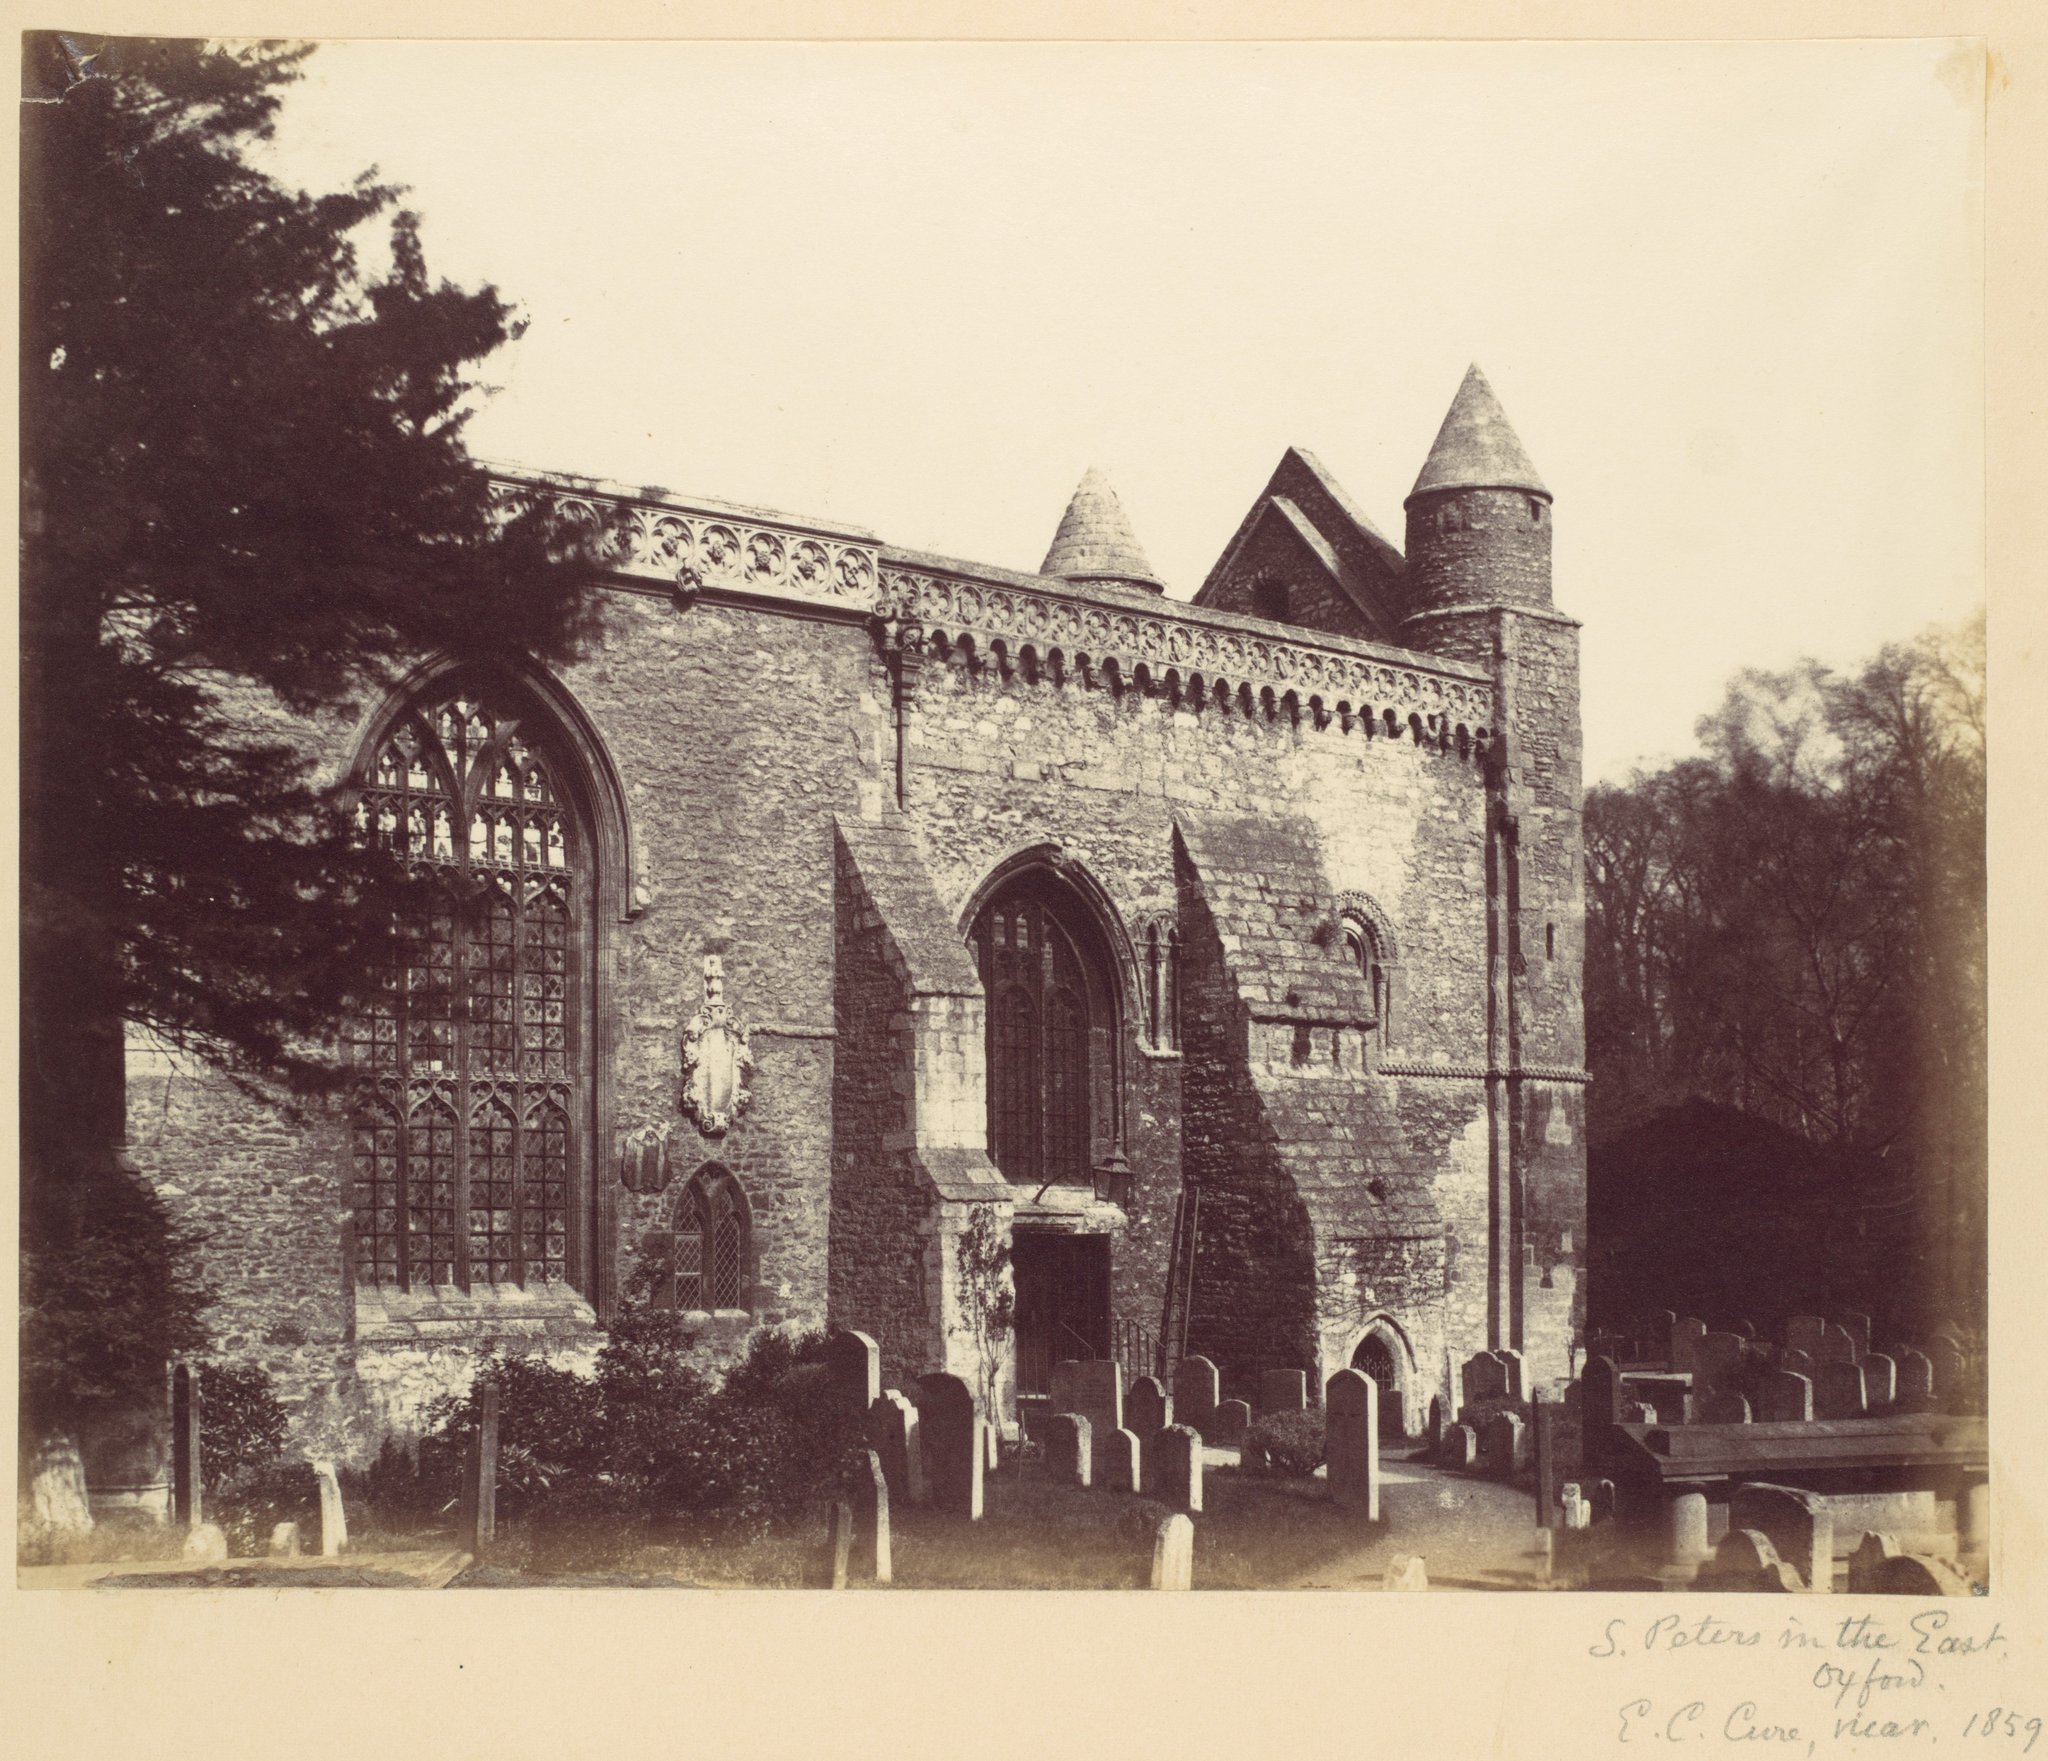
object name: photograph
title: St. Peter's in the East, Oxford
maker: alfred capel cure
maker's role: artist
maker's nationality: british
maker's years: 1826-1896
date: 1859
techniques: albumen silver print, paper negative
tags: architecture,churches,cemeteries